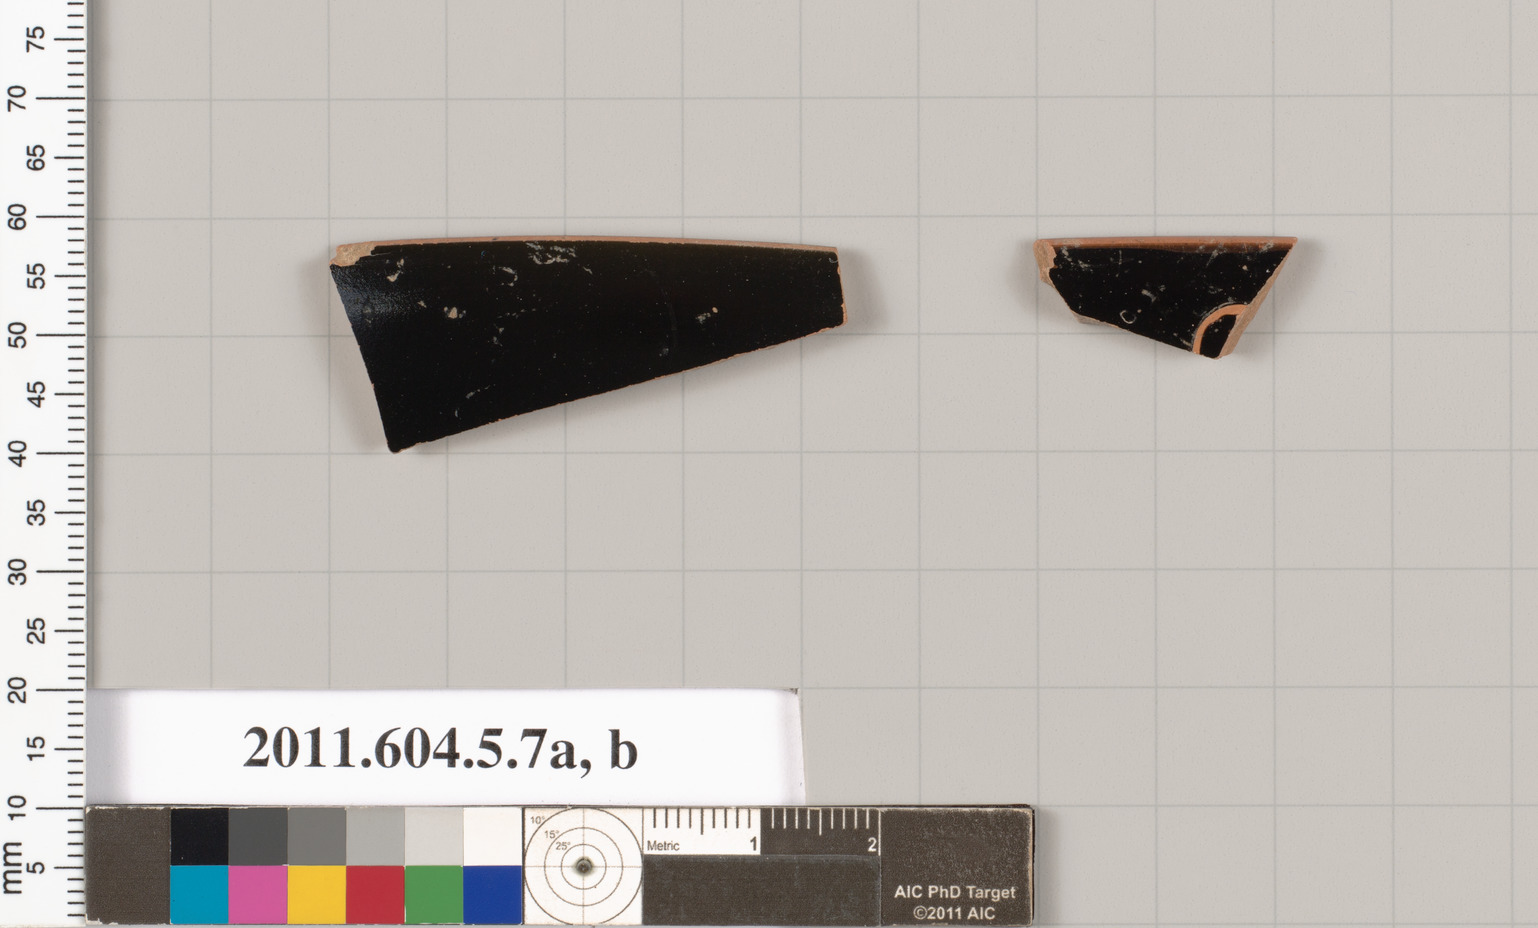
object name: kylix fragment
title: Terracotta rim fragments of a kylix (drinking cup)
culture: greek, attic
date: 475-451 BCE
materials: terracotta